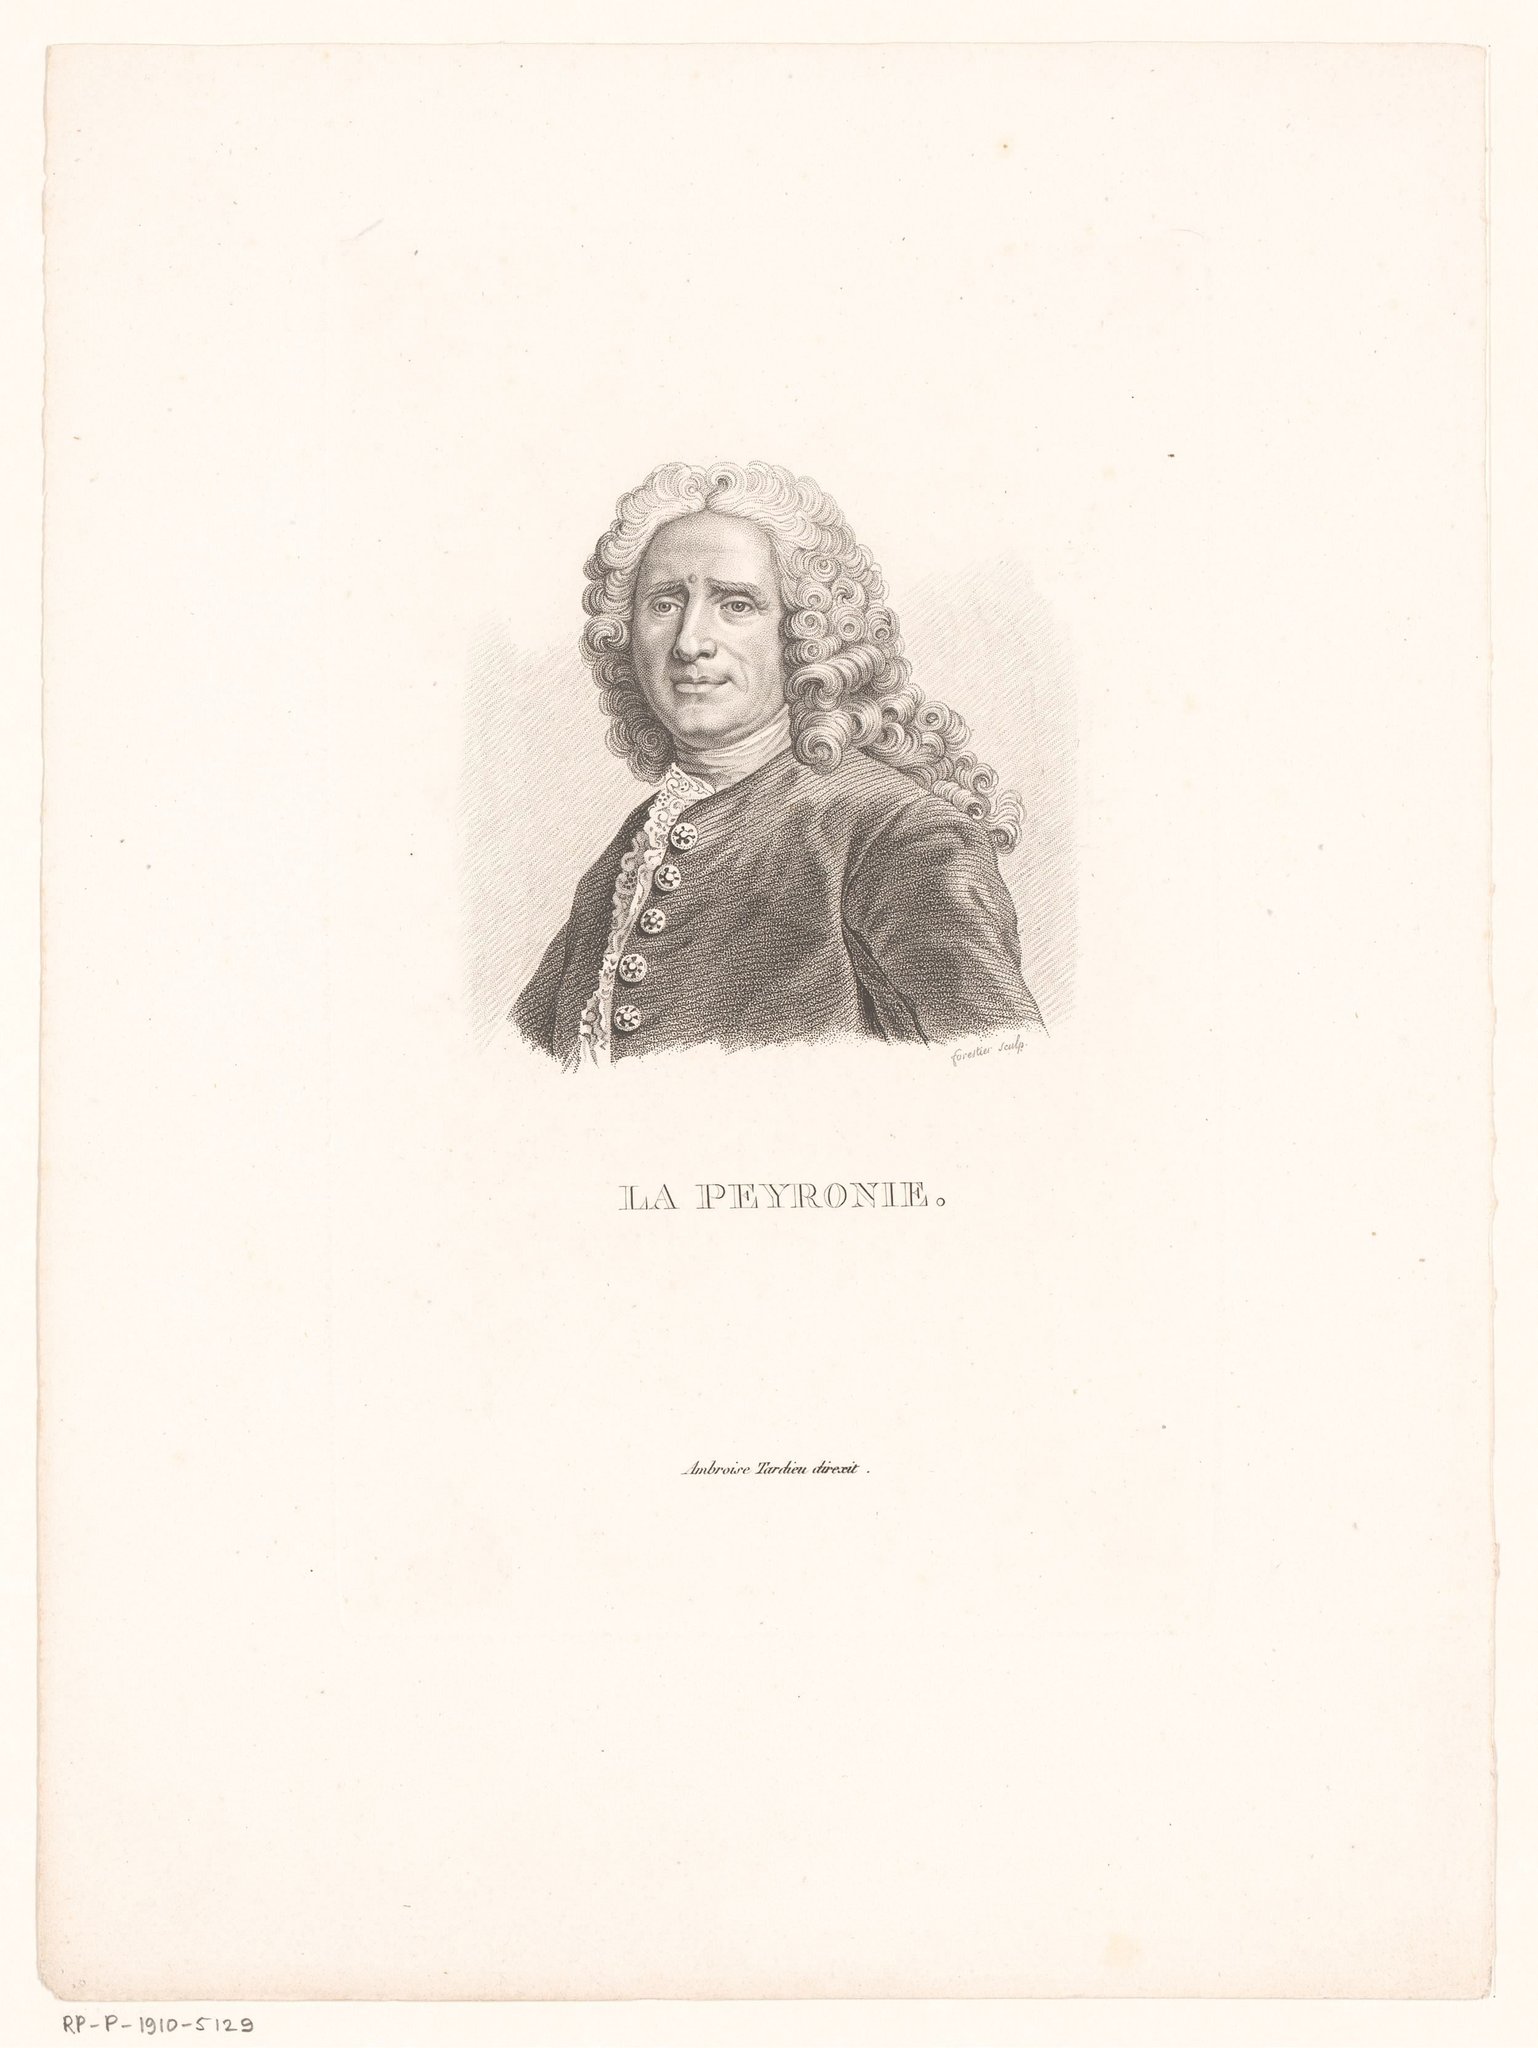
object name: print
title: Portret van François Gigot de la Peyronie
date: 1818-1832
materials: paper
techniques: engraving, roulette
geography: paris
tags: historical persons, barber; surgeon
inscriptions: collector's mark: Lugt 2228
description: Mogelijk prent uit: Journal complémentaire du Dictionnaire des sciences médicales. Parijs: Panckoucke, Charles Louis Fleury, 1818-1832.